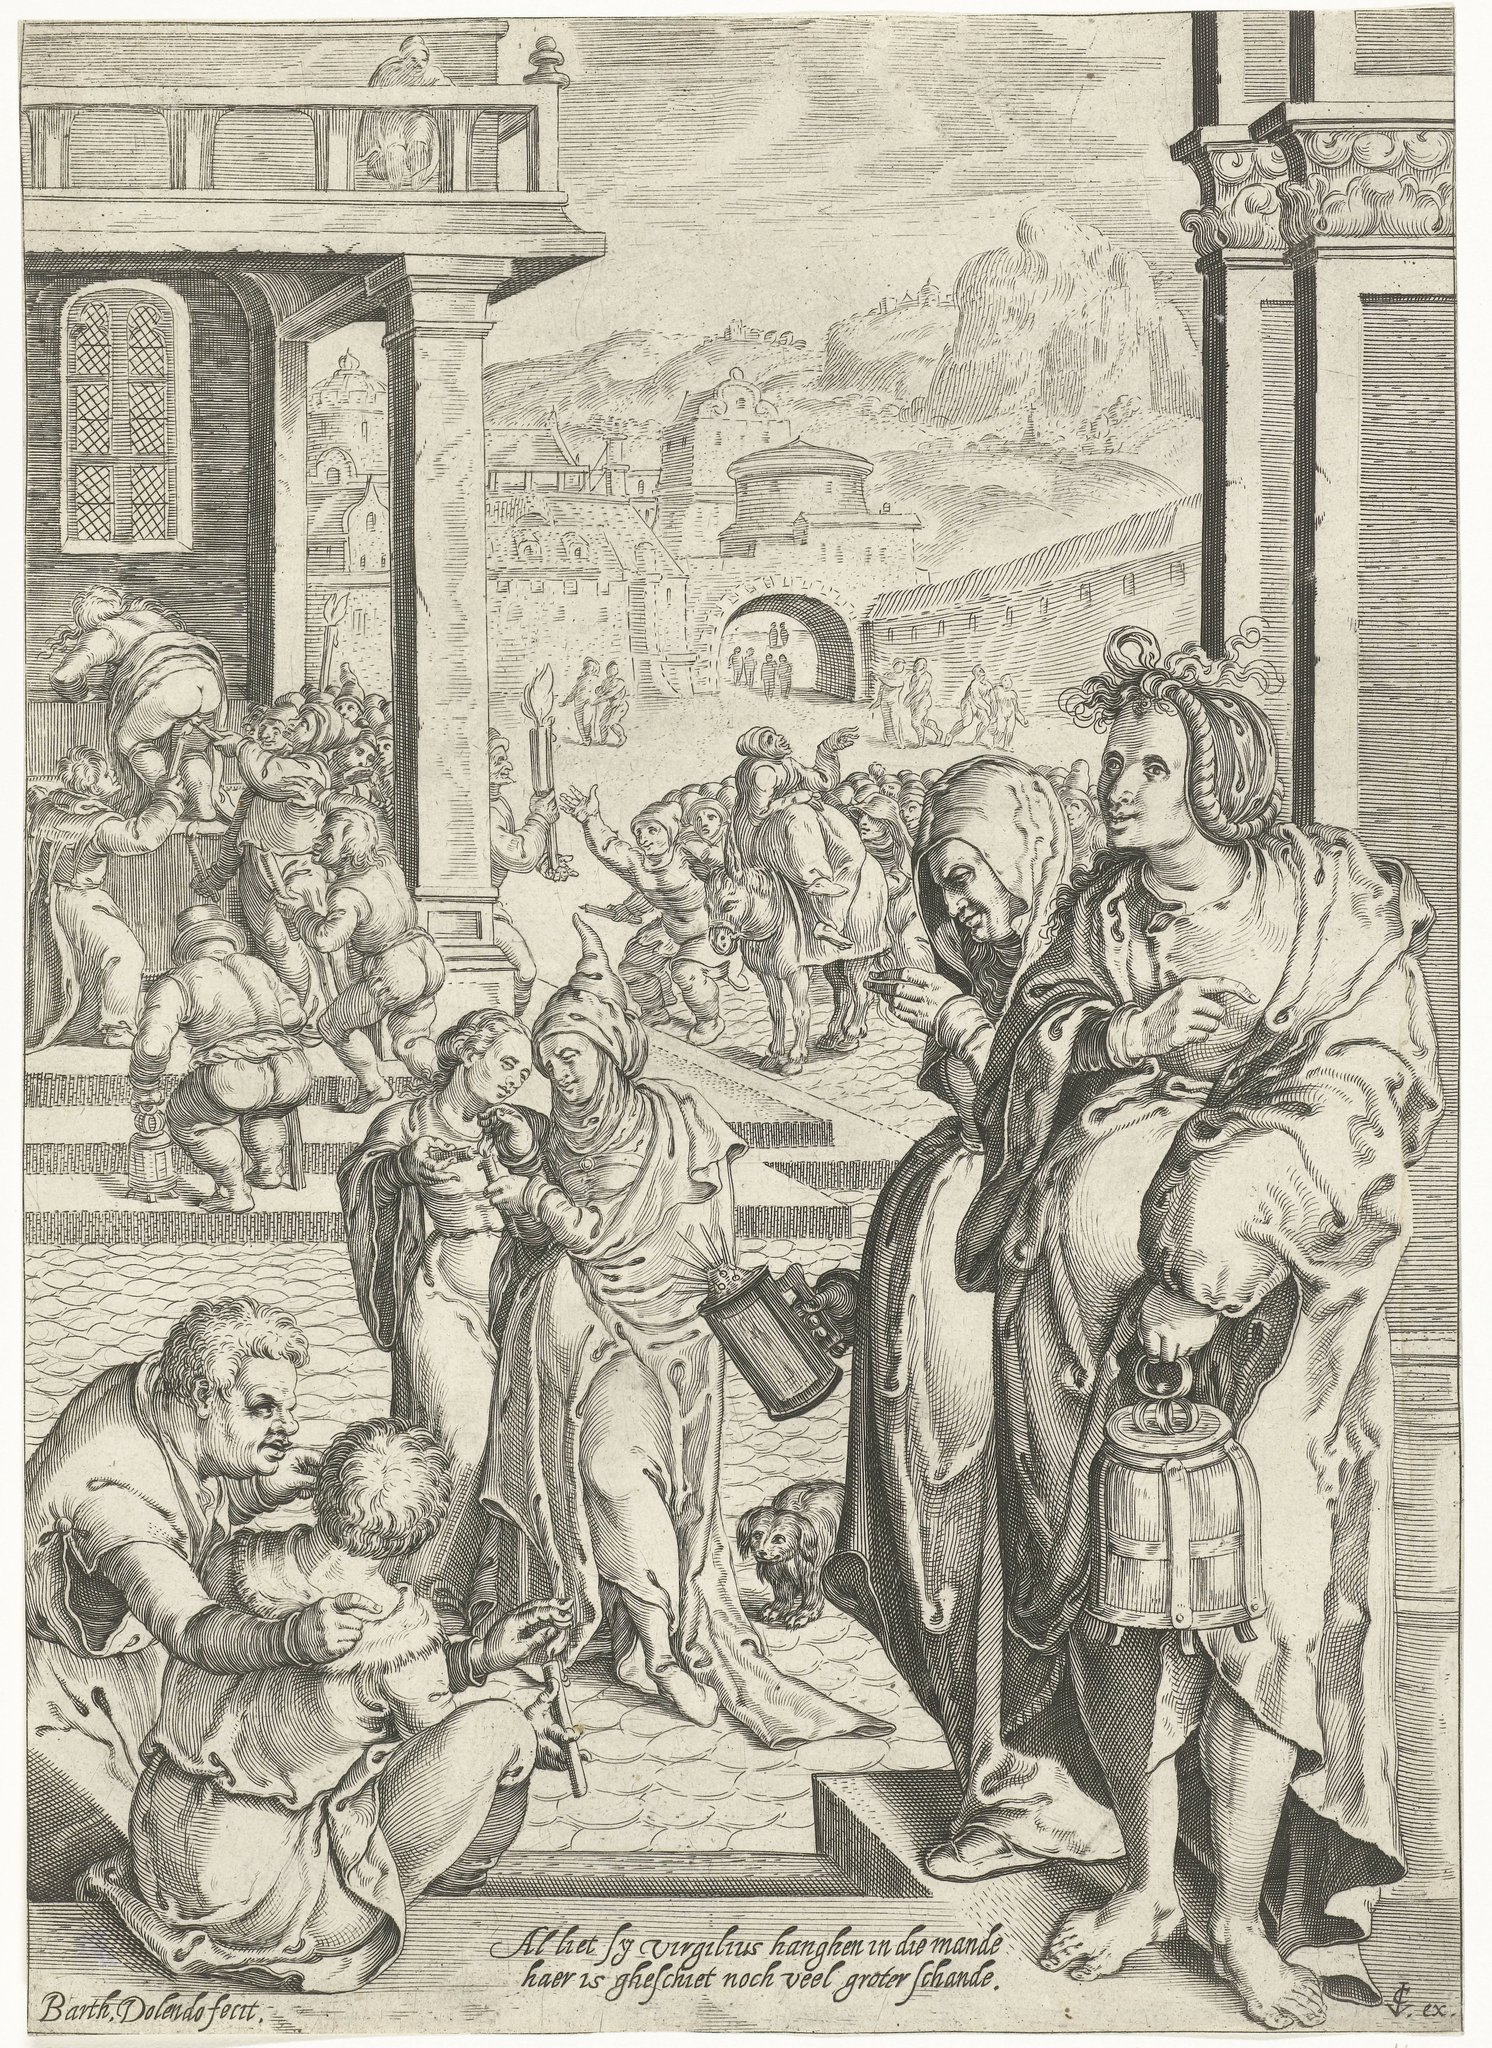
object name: print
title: De wraak van de tovenaar Vergilius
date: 1589-1626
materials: paper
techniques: engraving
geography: leiden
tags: square, place, circus, etc., virgil's revenge: men lighting candles at phyllis' behind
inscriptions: collector's mark: Lugt 1490, collector's mark: Lugt 2228, caption: ‘Al siet gy Virgilius hanghen in die mande/ haer is gheschiet nogh veel groter schande’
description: Op een marktplaats verzamelen zich mensen met lantaarens en kaarsen. Door de wraak van de tovenaar Vergilius is in heel Rome het vuur gedoofd. Om nieuw vuur te kunnen krijgen moeten de bewoners het vuur gaan halen bij Lucretias naakte billen. Zij had Vergilius vernedert door hem een nacht lang in een mand voor haar raam te laten hangen. Nu vernedert hij haar voor het volk.